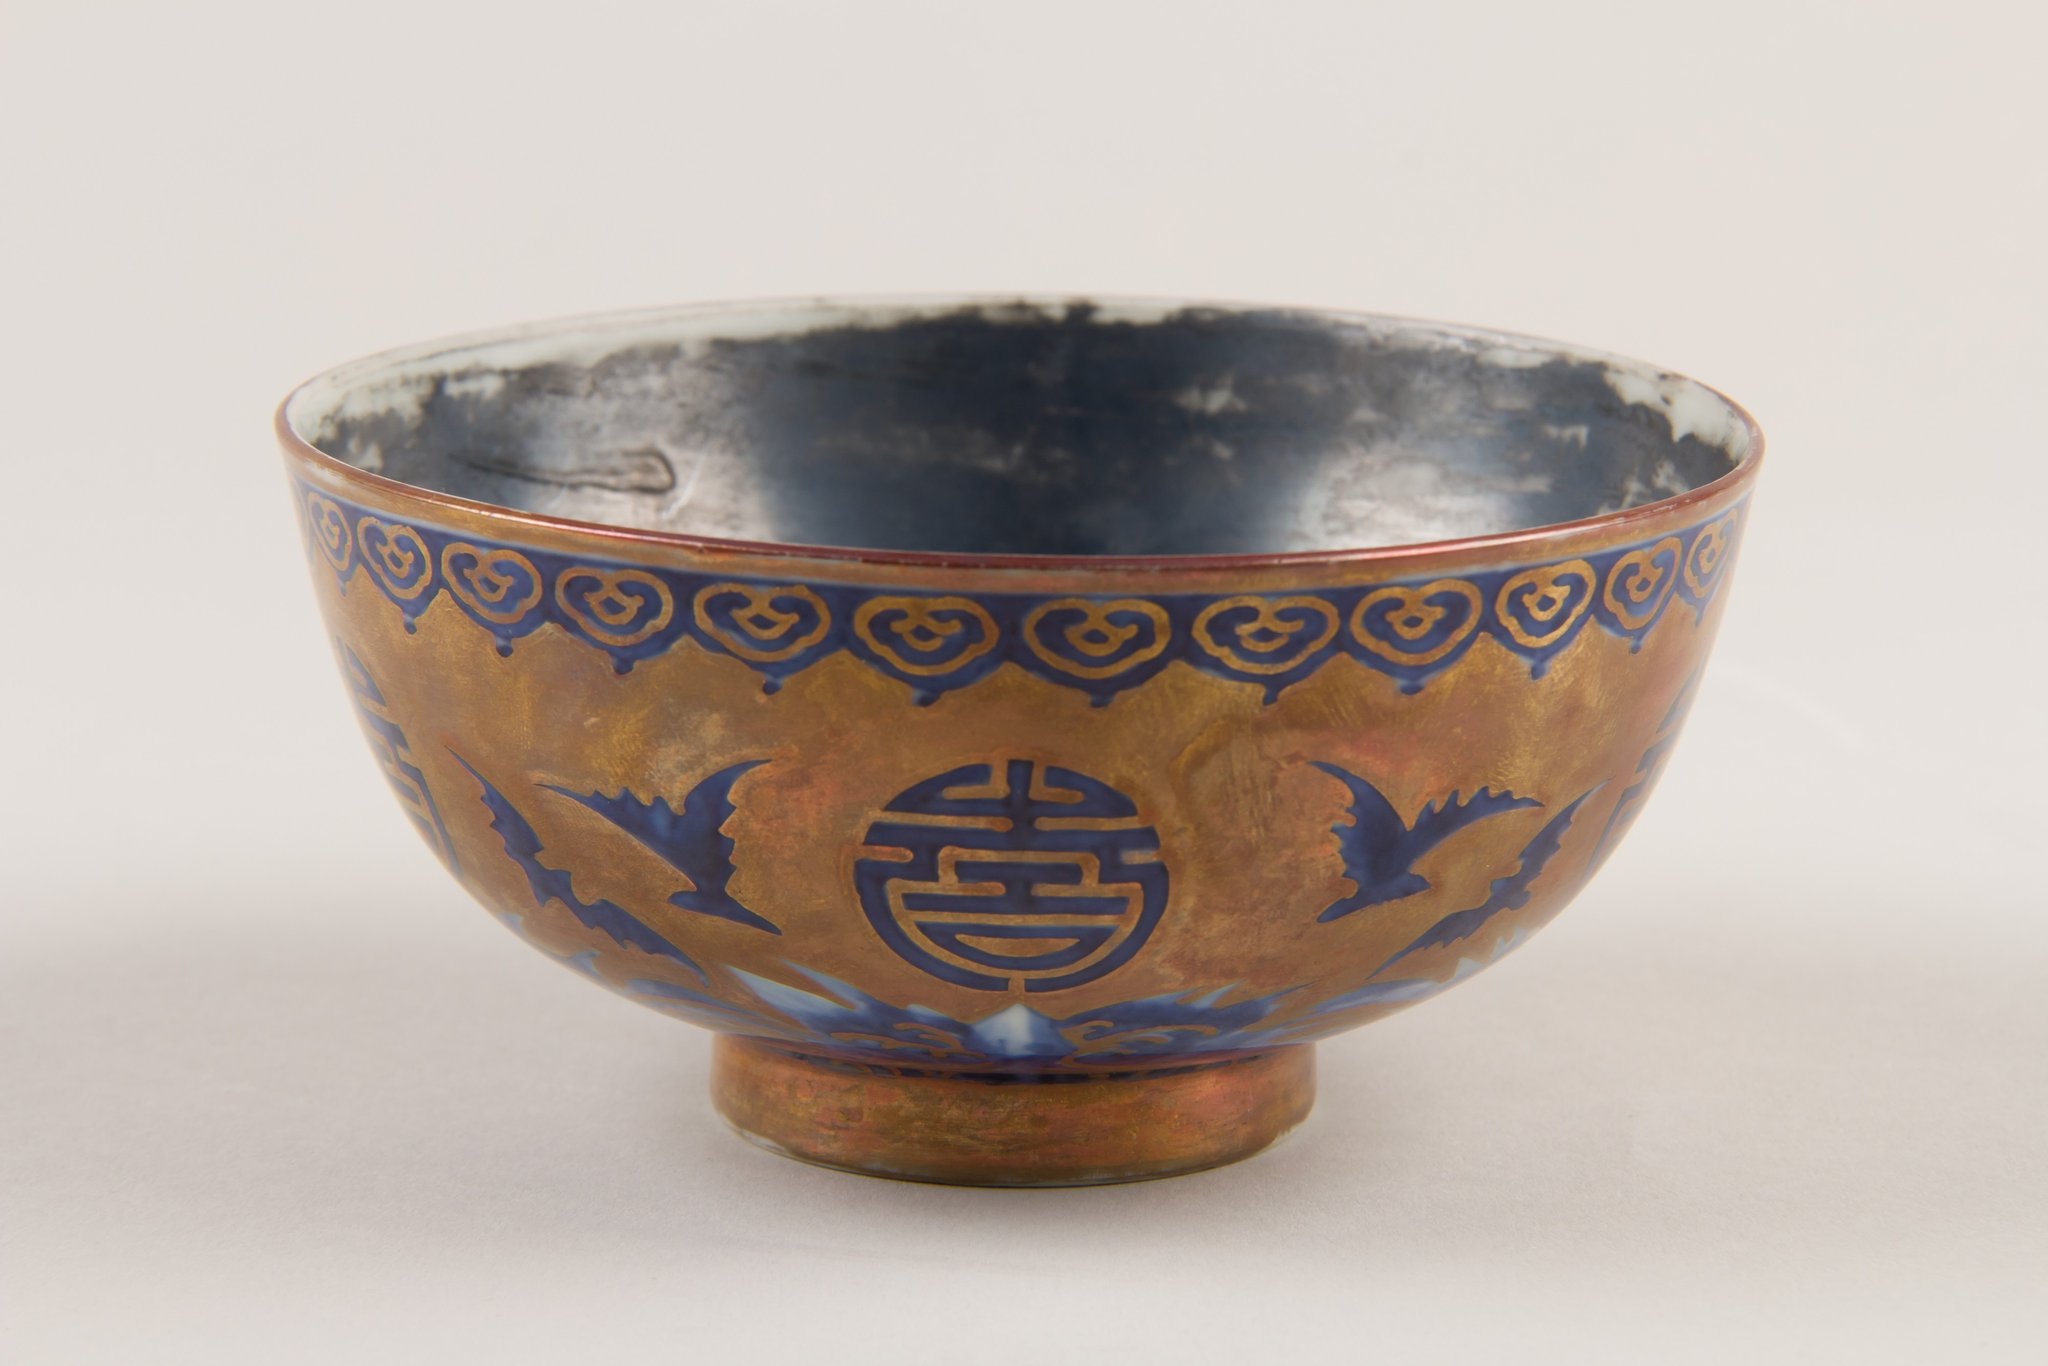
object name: bowl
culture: chinese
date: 1701-1800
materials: porcelain